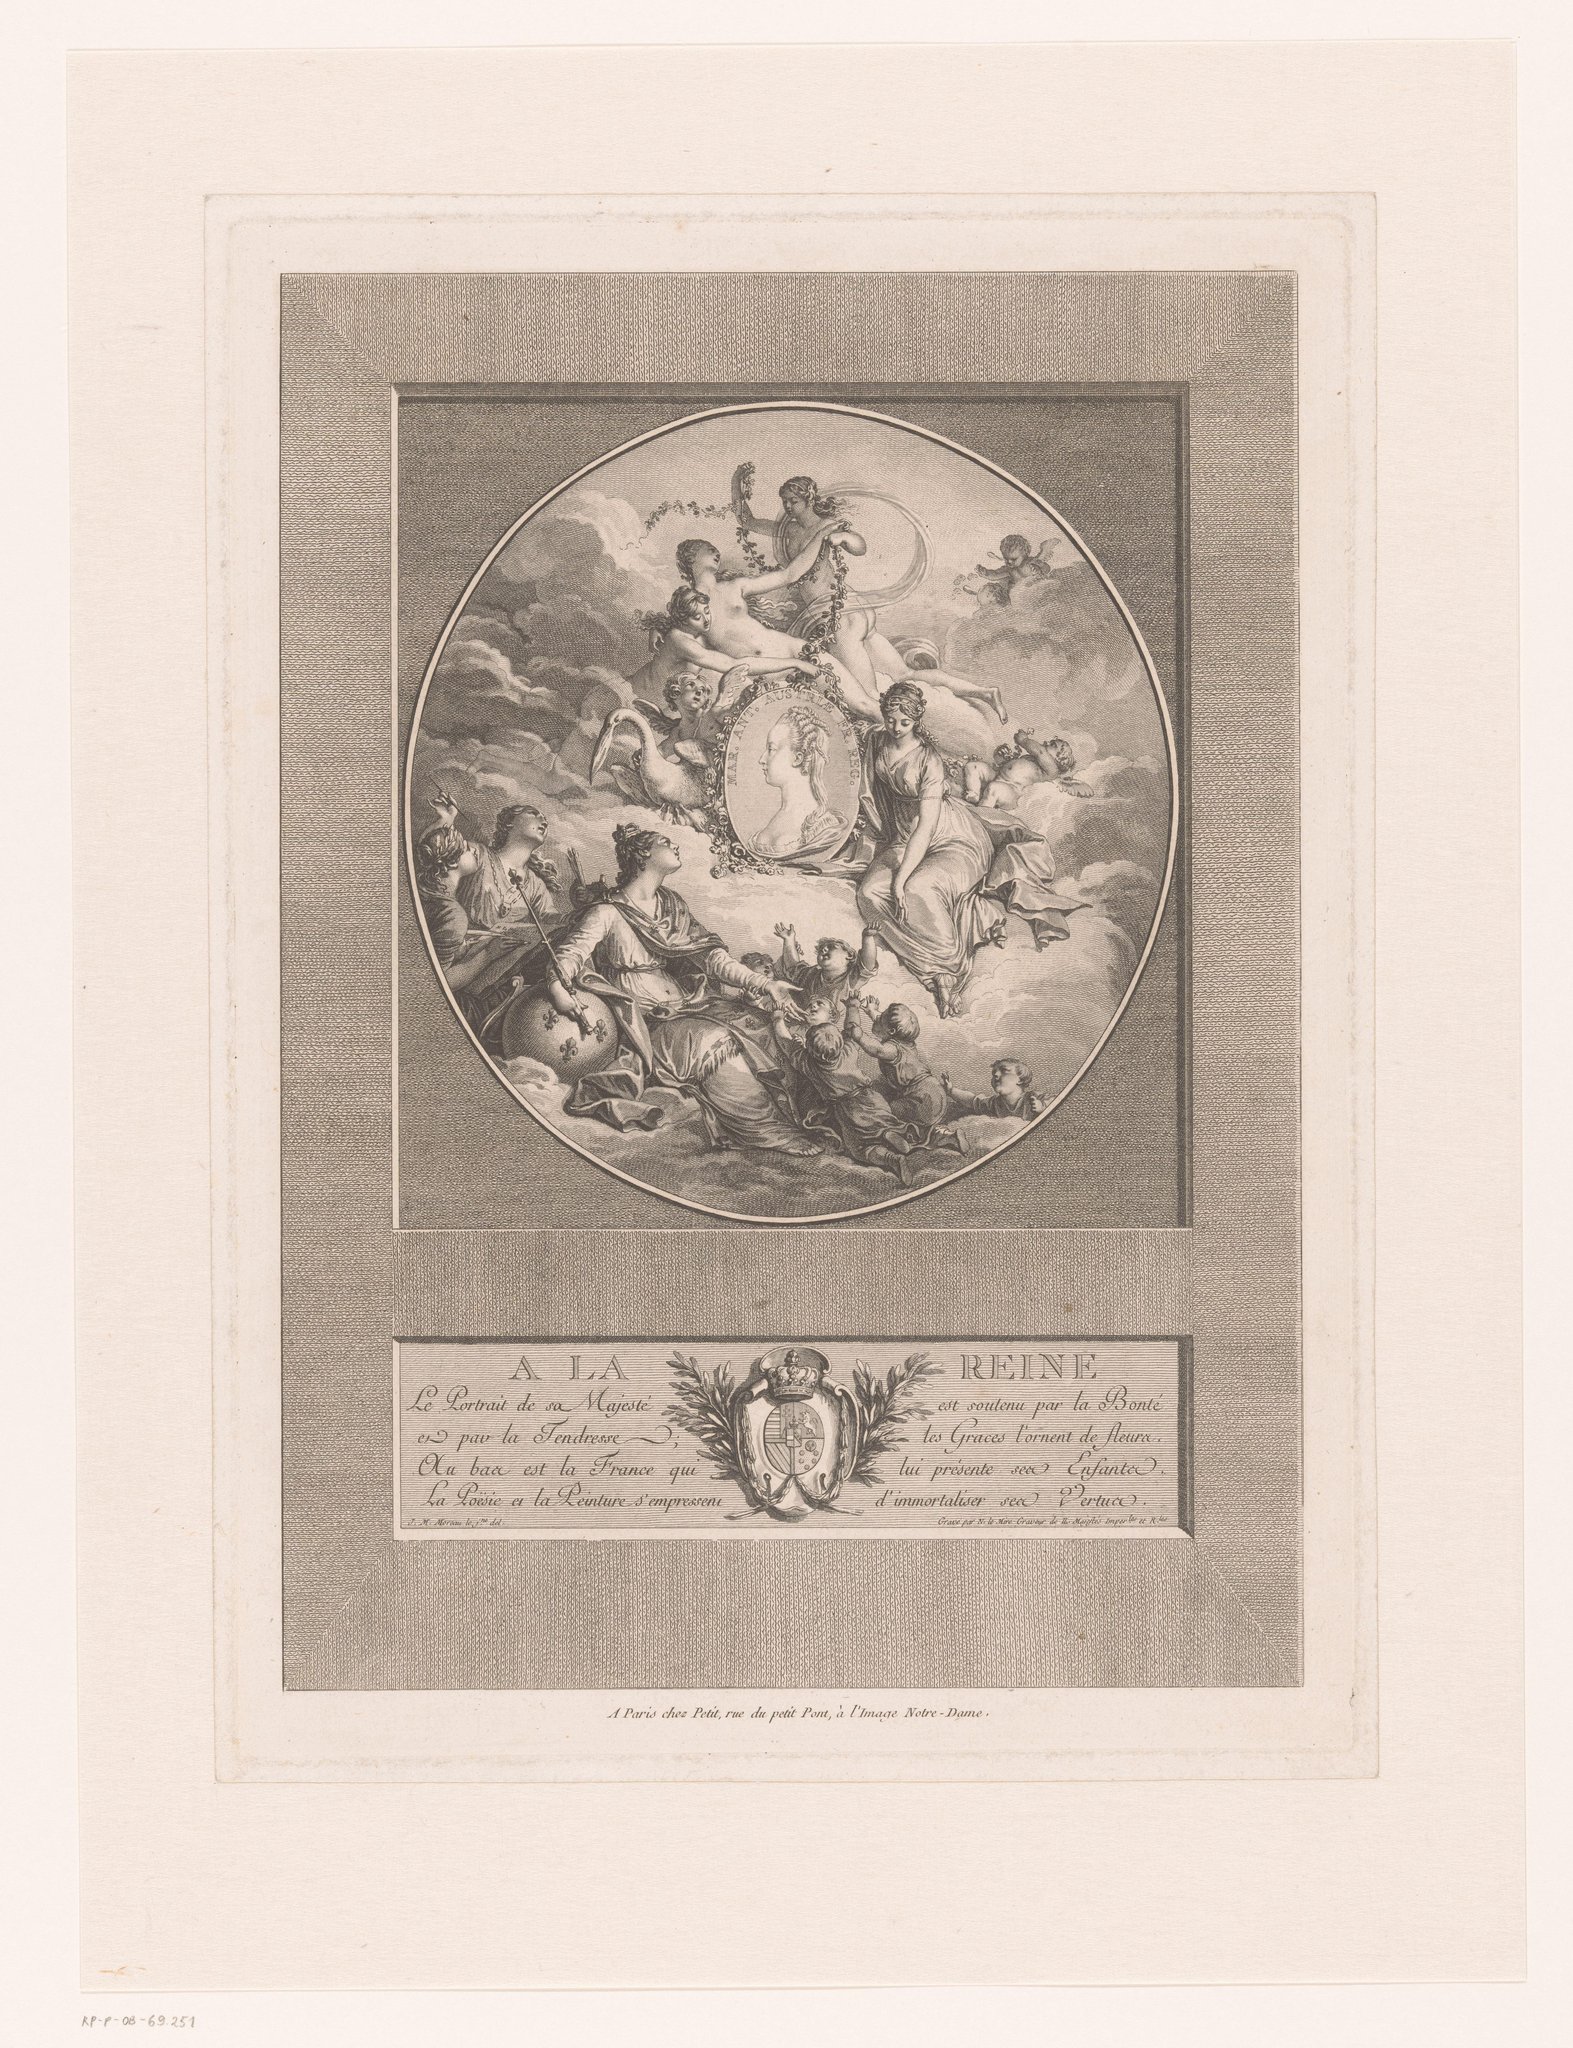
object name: print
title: Medaillon met portret van Marie Antoinette omringd door allegorische figuren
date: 1774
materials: paper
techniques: engraving, etching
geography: paris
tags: vienna, paris, marie antoinette, historical persons - bb - woman, ornament ~ medallion, armorial bearing, heraldry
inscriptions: collector's mark: Lugt 2228